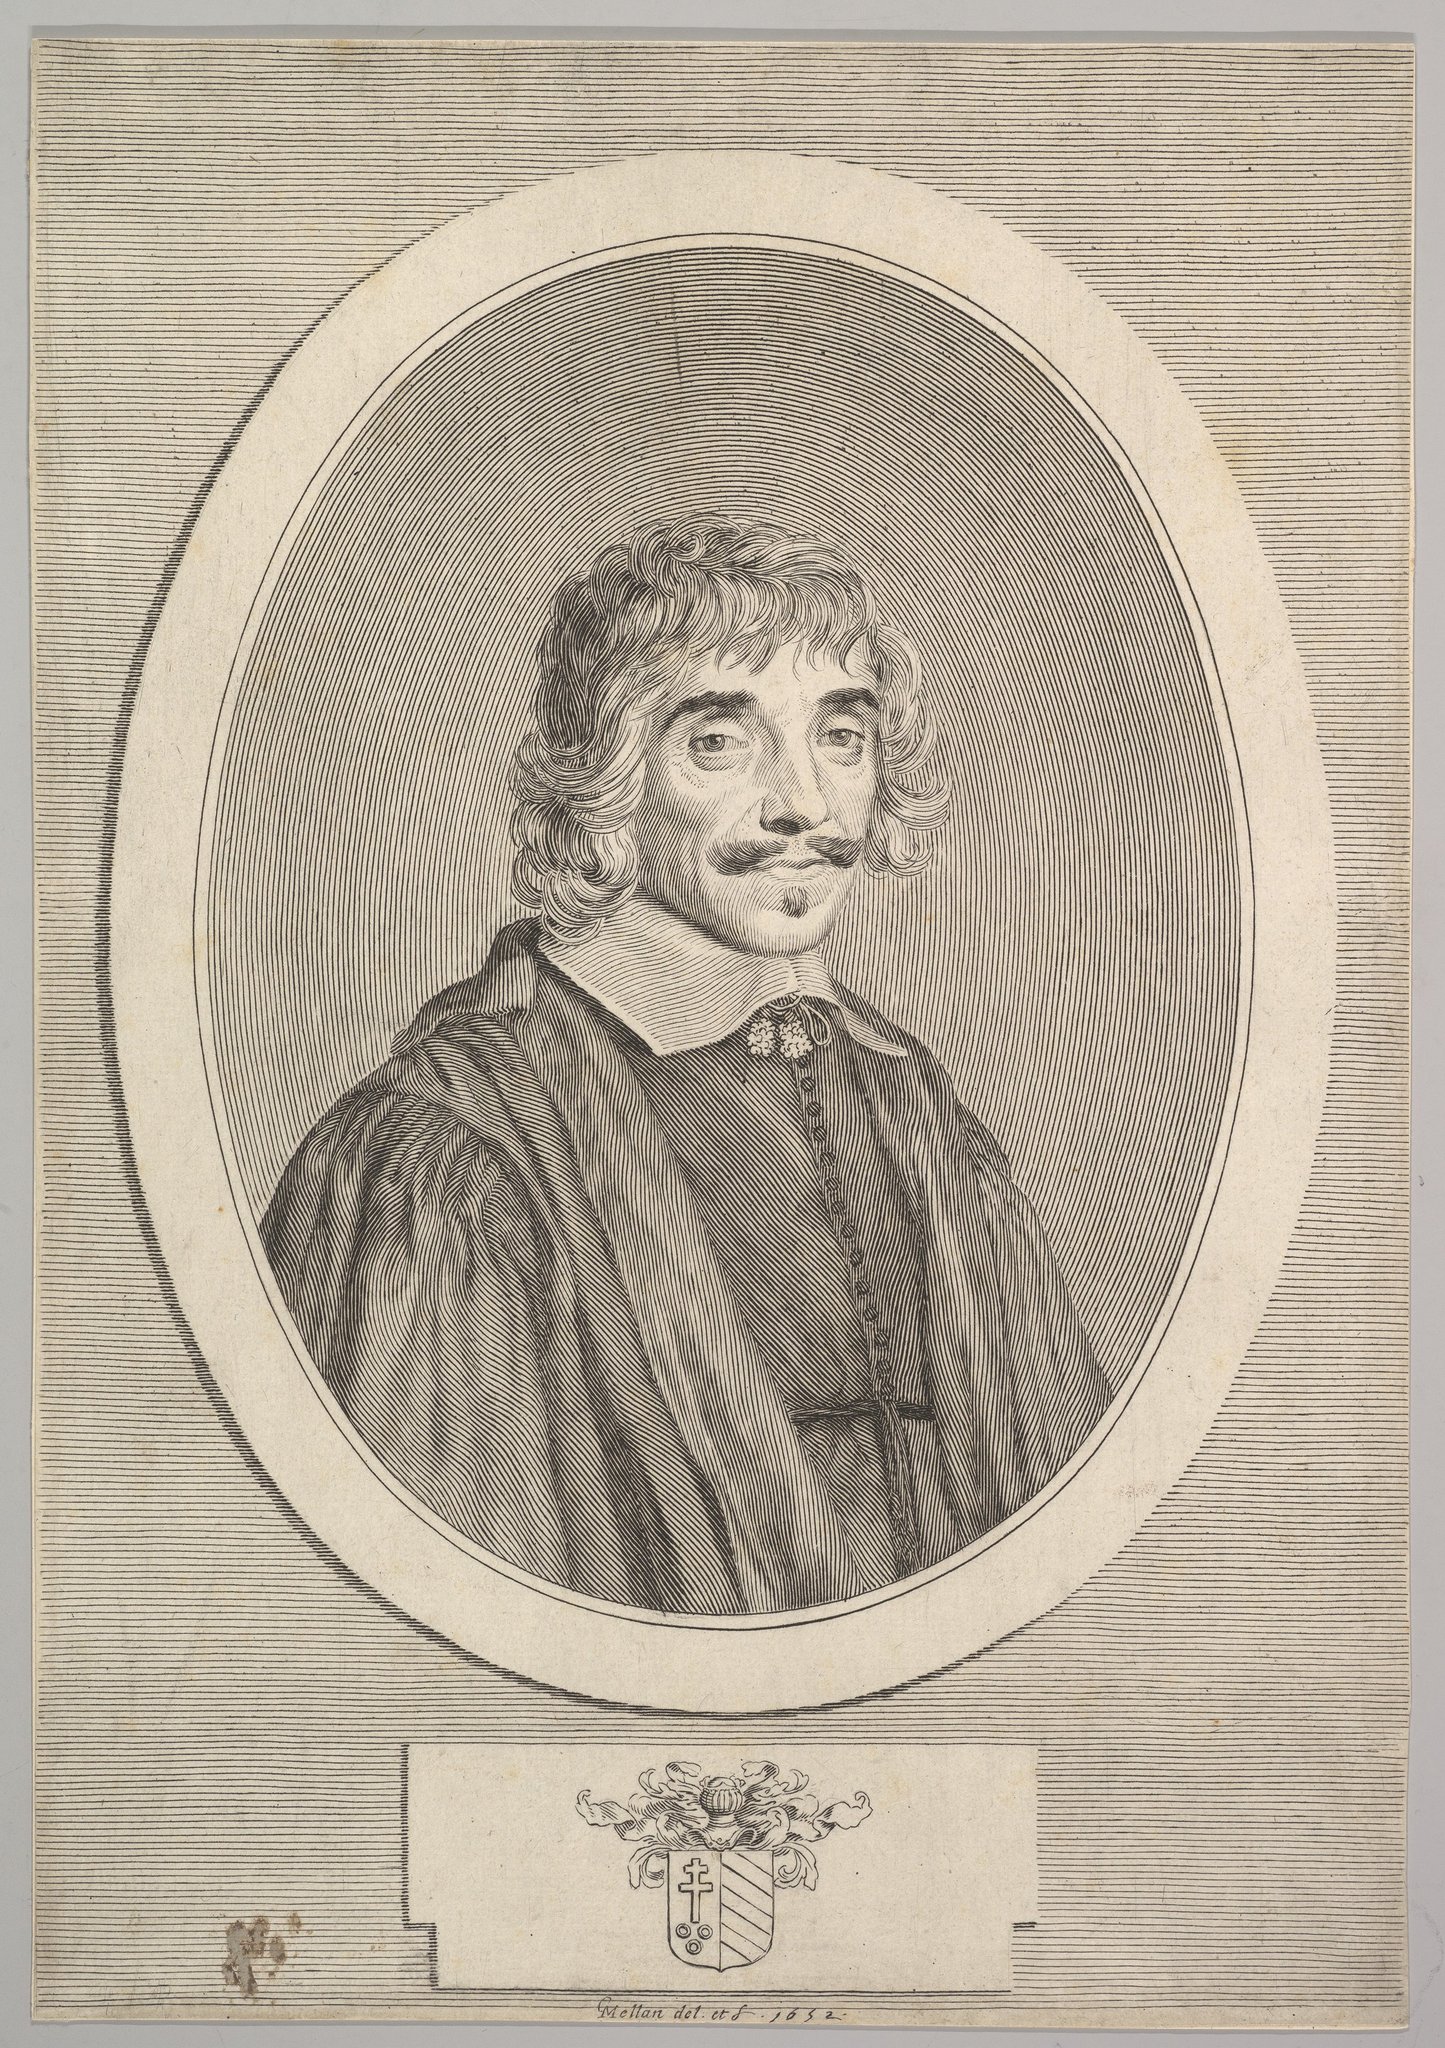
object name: print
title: Jean Perrault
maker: claude mellan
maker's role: artist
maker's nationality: french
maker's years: 1598-1688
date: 1652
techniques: engraving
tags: men,portraits